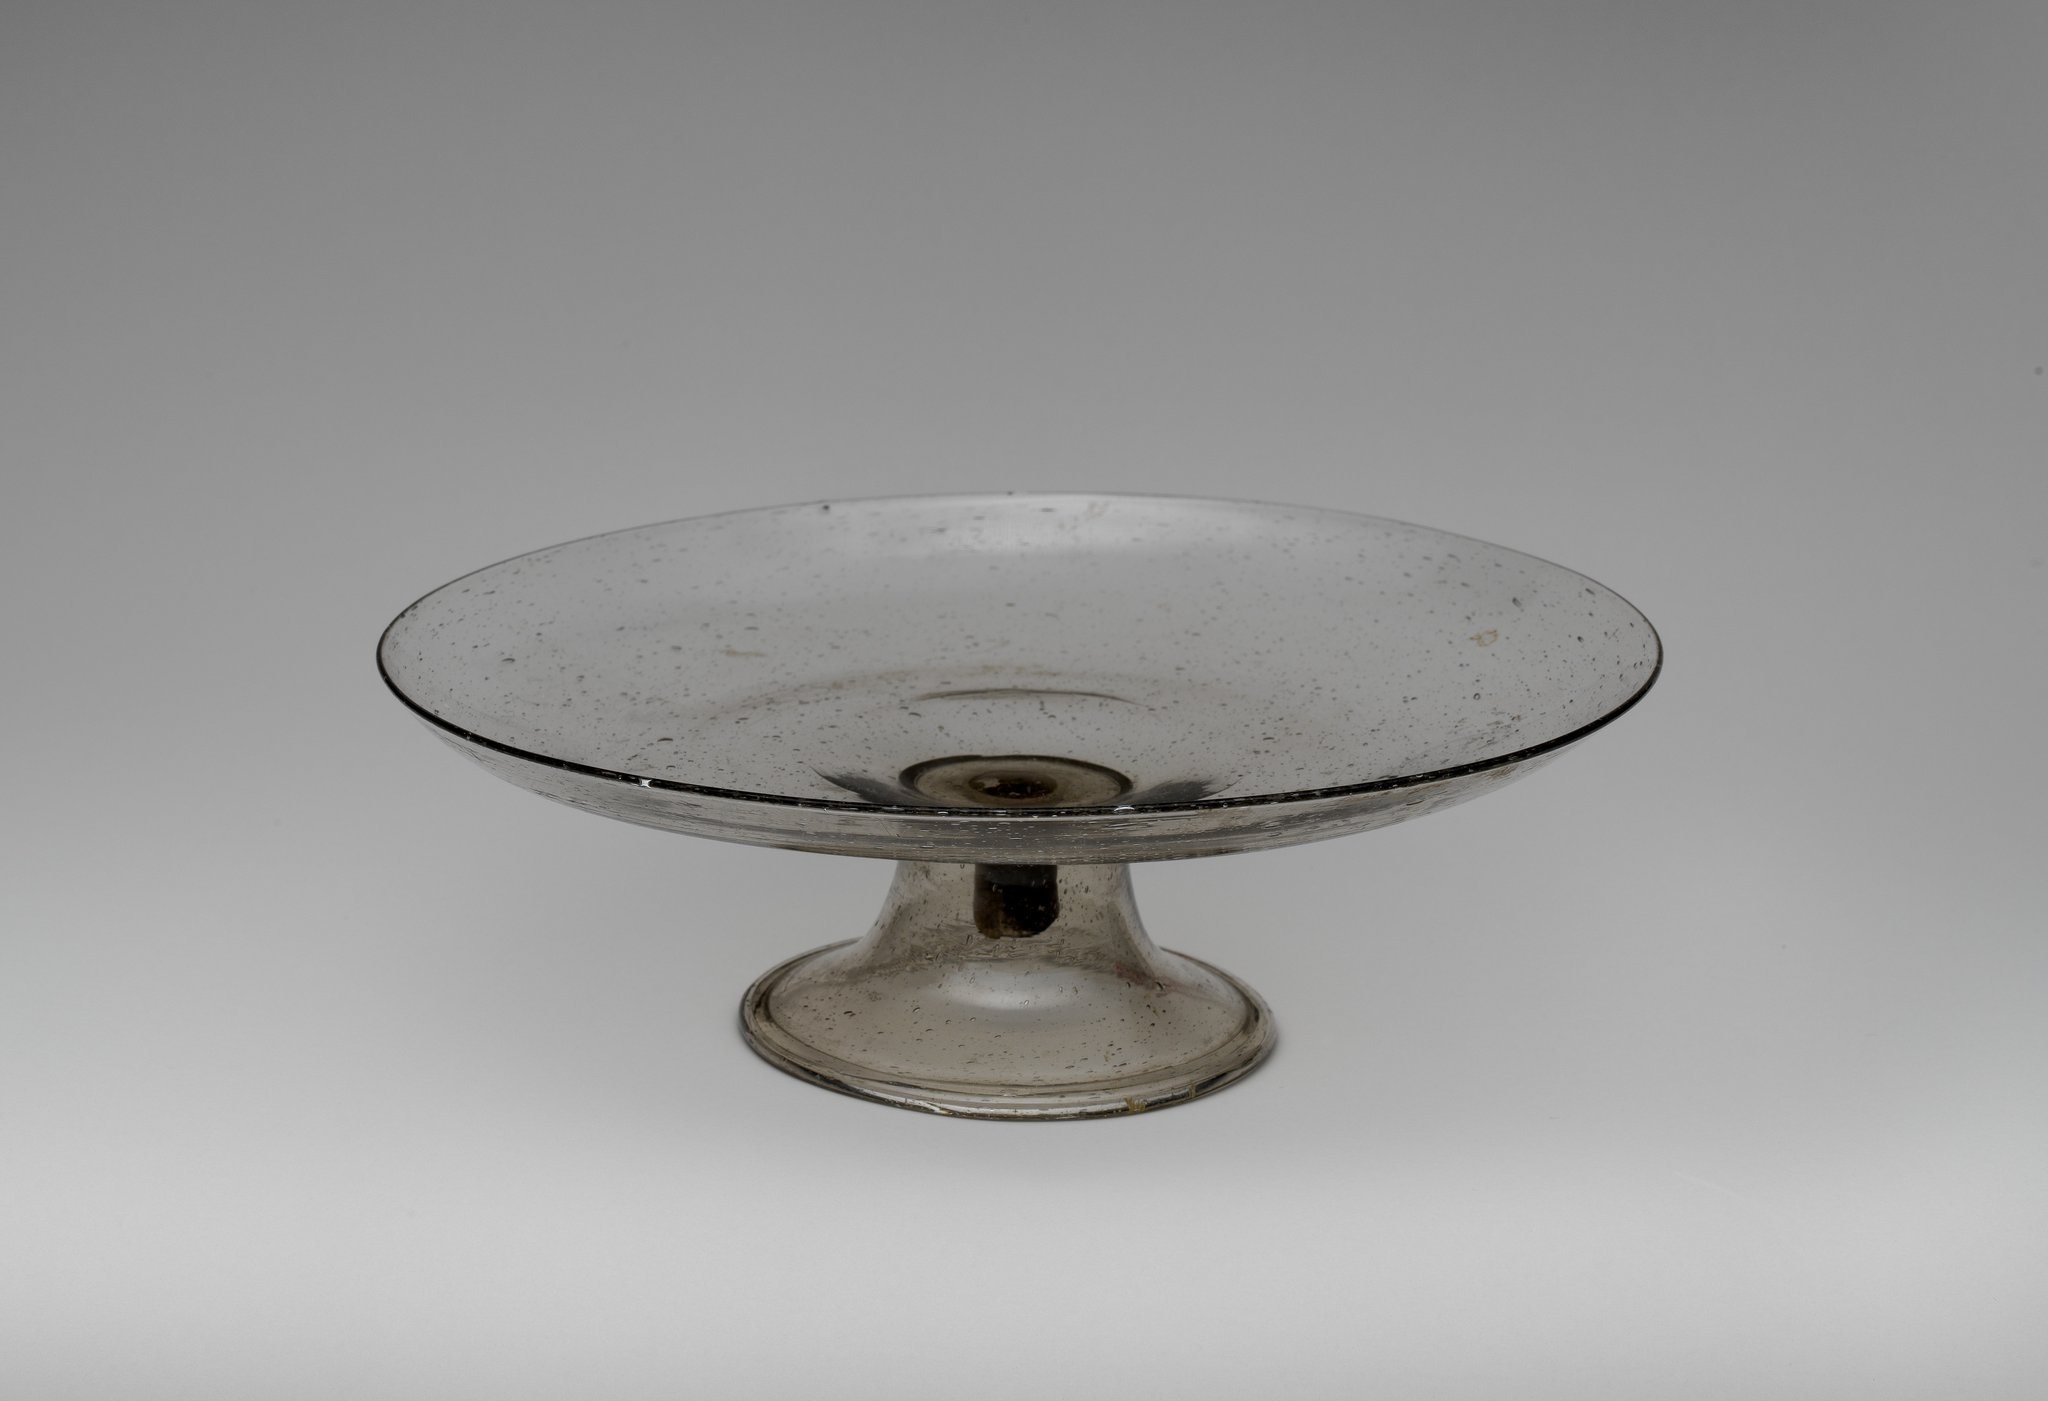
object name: tazza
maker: glasshouse of the duke of buckingham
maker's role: manufactory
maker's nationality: british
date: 1665-1670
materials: glass